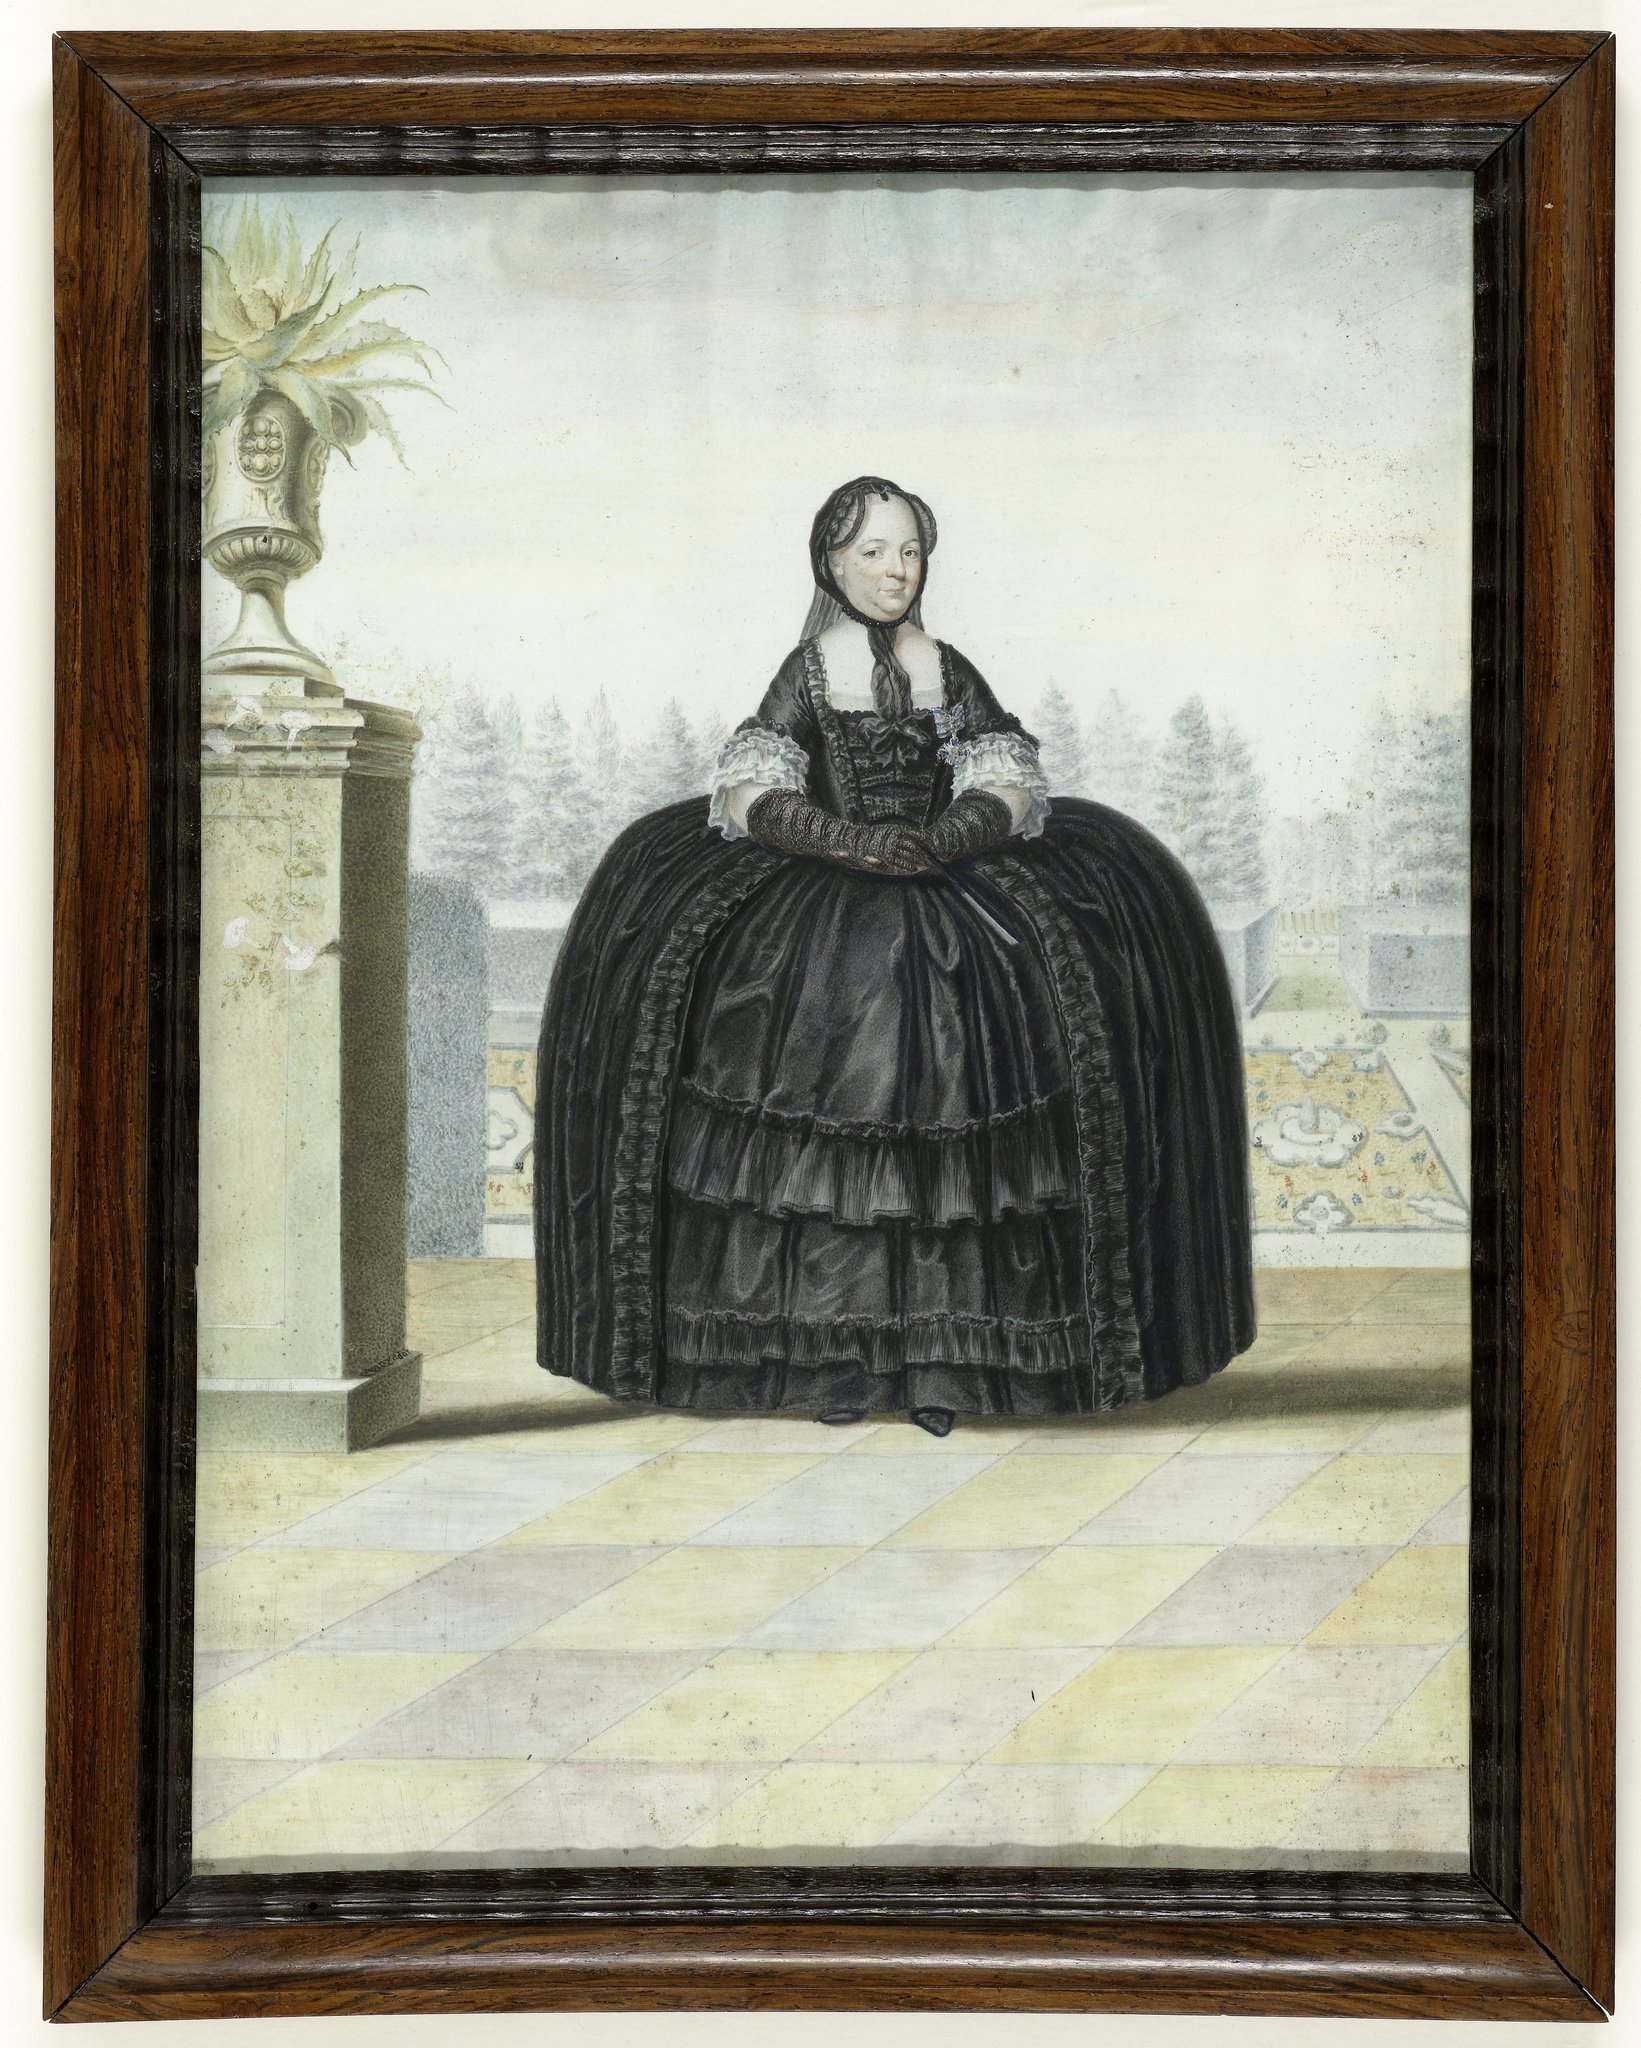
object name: drawing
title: Portrait of Empress Maria Theresa of Austria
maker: ignaz manzador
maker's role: draughtsman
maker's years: 1740-1791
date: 1765-1791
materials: gouache, parchment, watercolor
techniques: brush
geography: austria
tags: maria theresia (rooms-duits keizerin)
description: It is unclear whether Empress Maria Theresa (1717-1780) is here looking out over the gardens of the Schönbrunn summer residence, which was built during her reign. She wears mourning clothes for the death of her husband, Francis of Lorraine, in 1765. Ignaz Manzador was a Viennese miniature painter. He emphasized the translucent nature of parchment by choosing a double-sided depiction: we see Maria Theresa portrayed from the front and from the back.